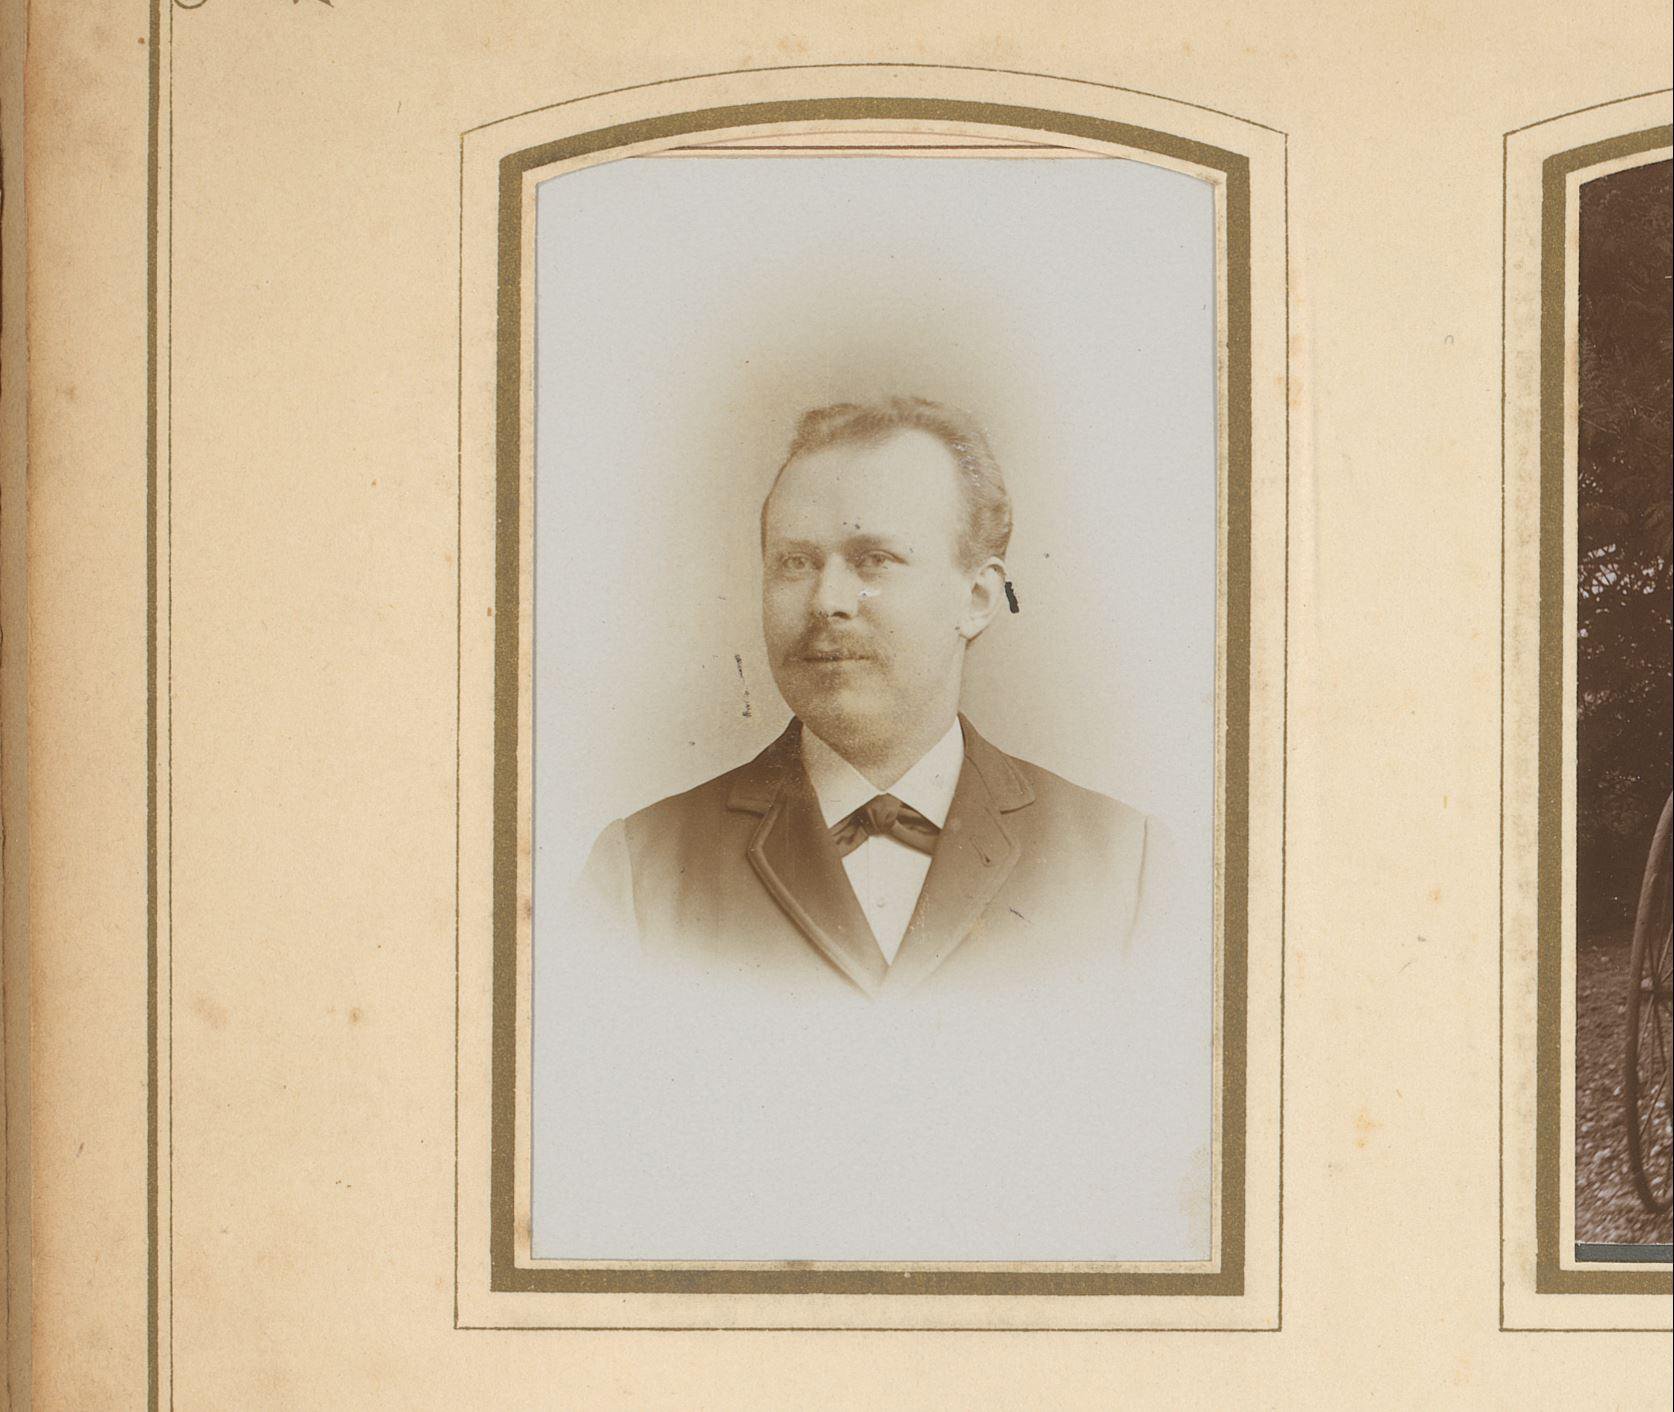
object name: photograph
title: Portret van een man met snor en vlinderstrik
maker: Anonymous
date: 1880-1920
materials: cardboard, photographic support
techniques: collodion silver print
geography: netherlands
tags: moustache, historical persons